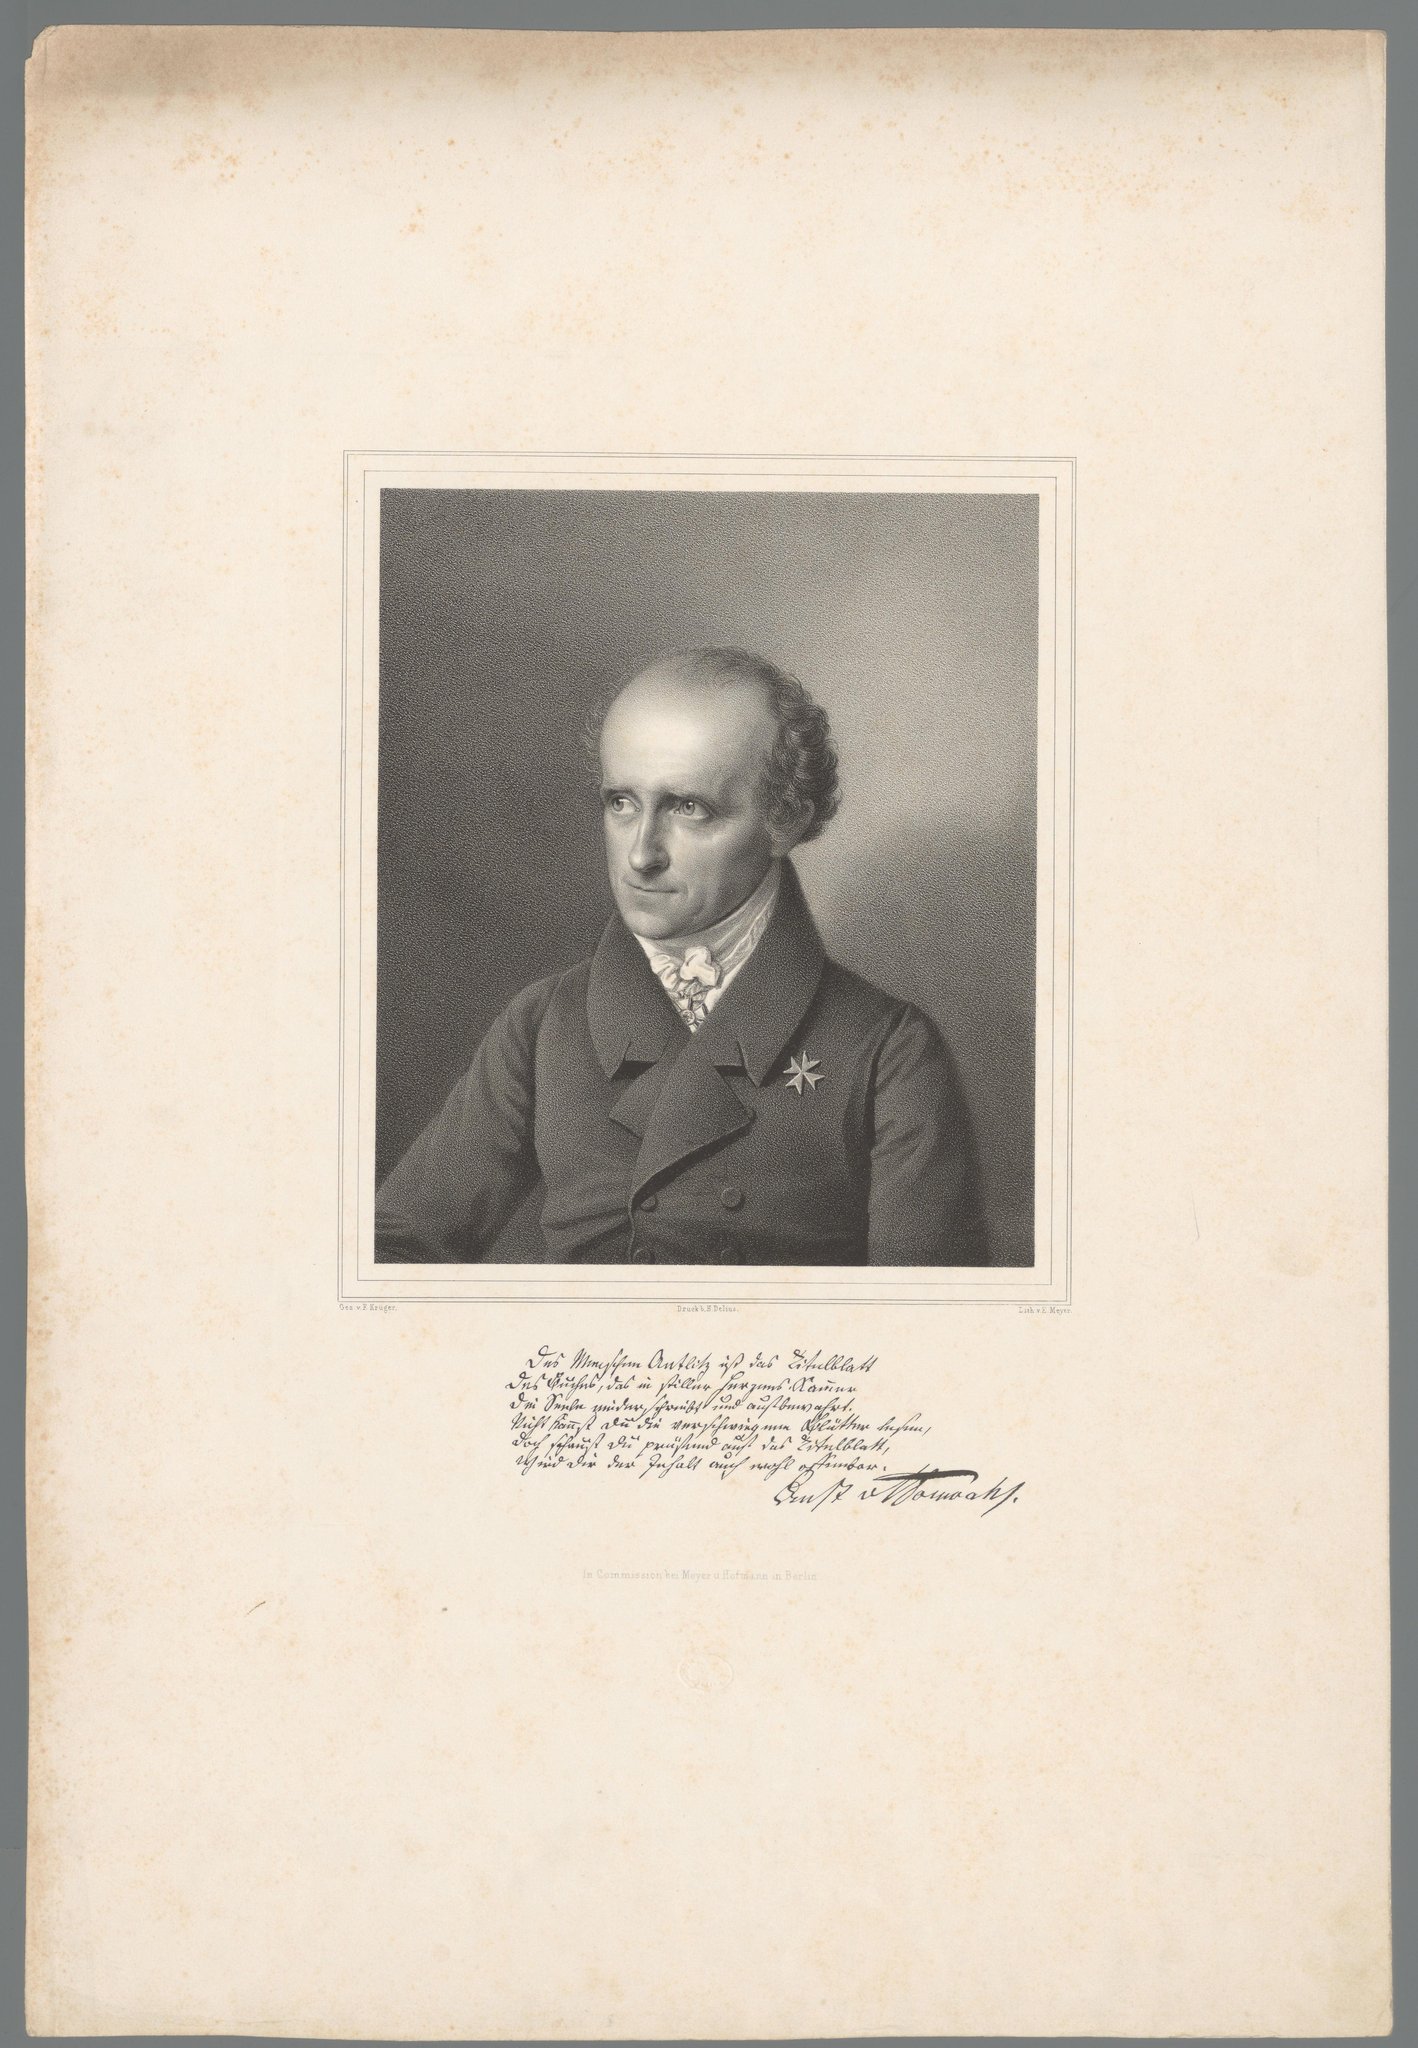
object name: print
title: Portret van een onbekende man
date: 1807-1857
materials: paper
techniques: lithograph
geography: berlin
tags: historical persons not known by name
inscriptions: check stamp: ‘Meyer & Hofmann in Berlin’, collector's mark: Lugt 2228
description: Portret van een verder onbekende man, met handtekening in facsimile waarin alleen de naam Ernst v. te lezen is.